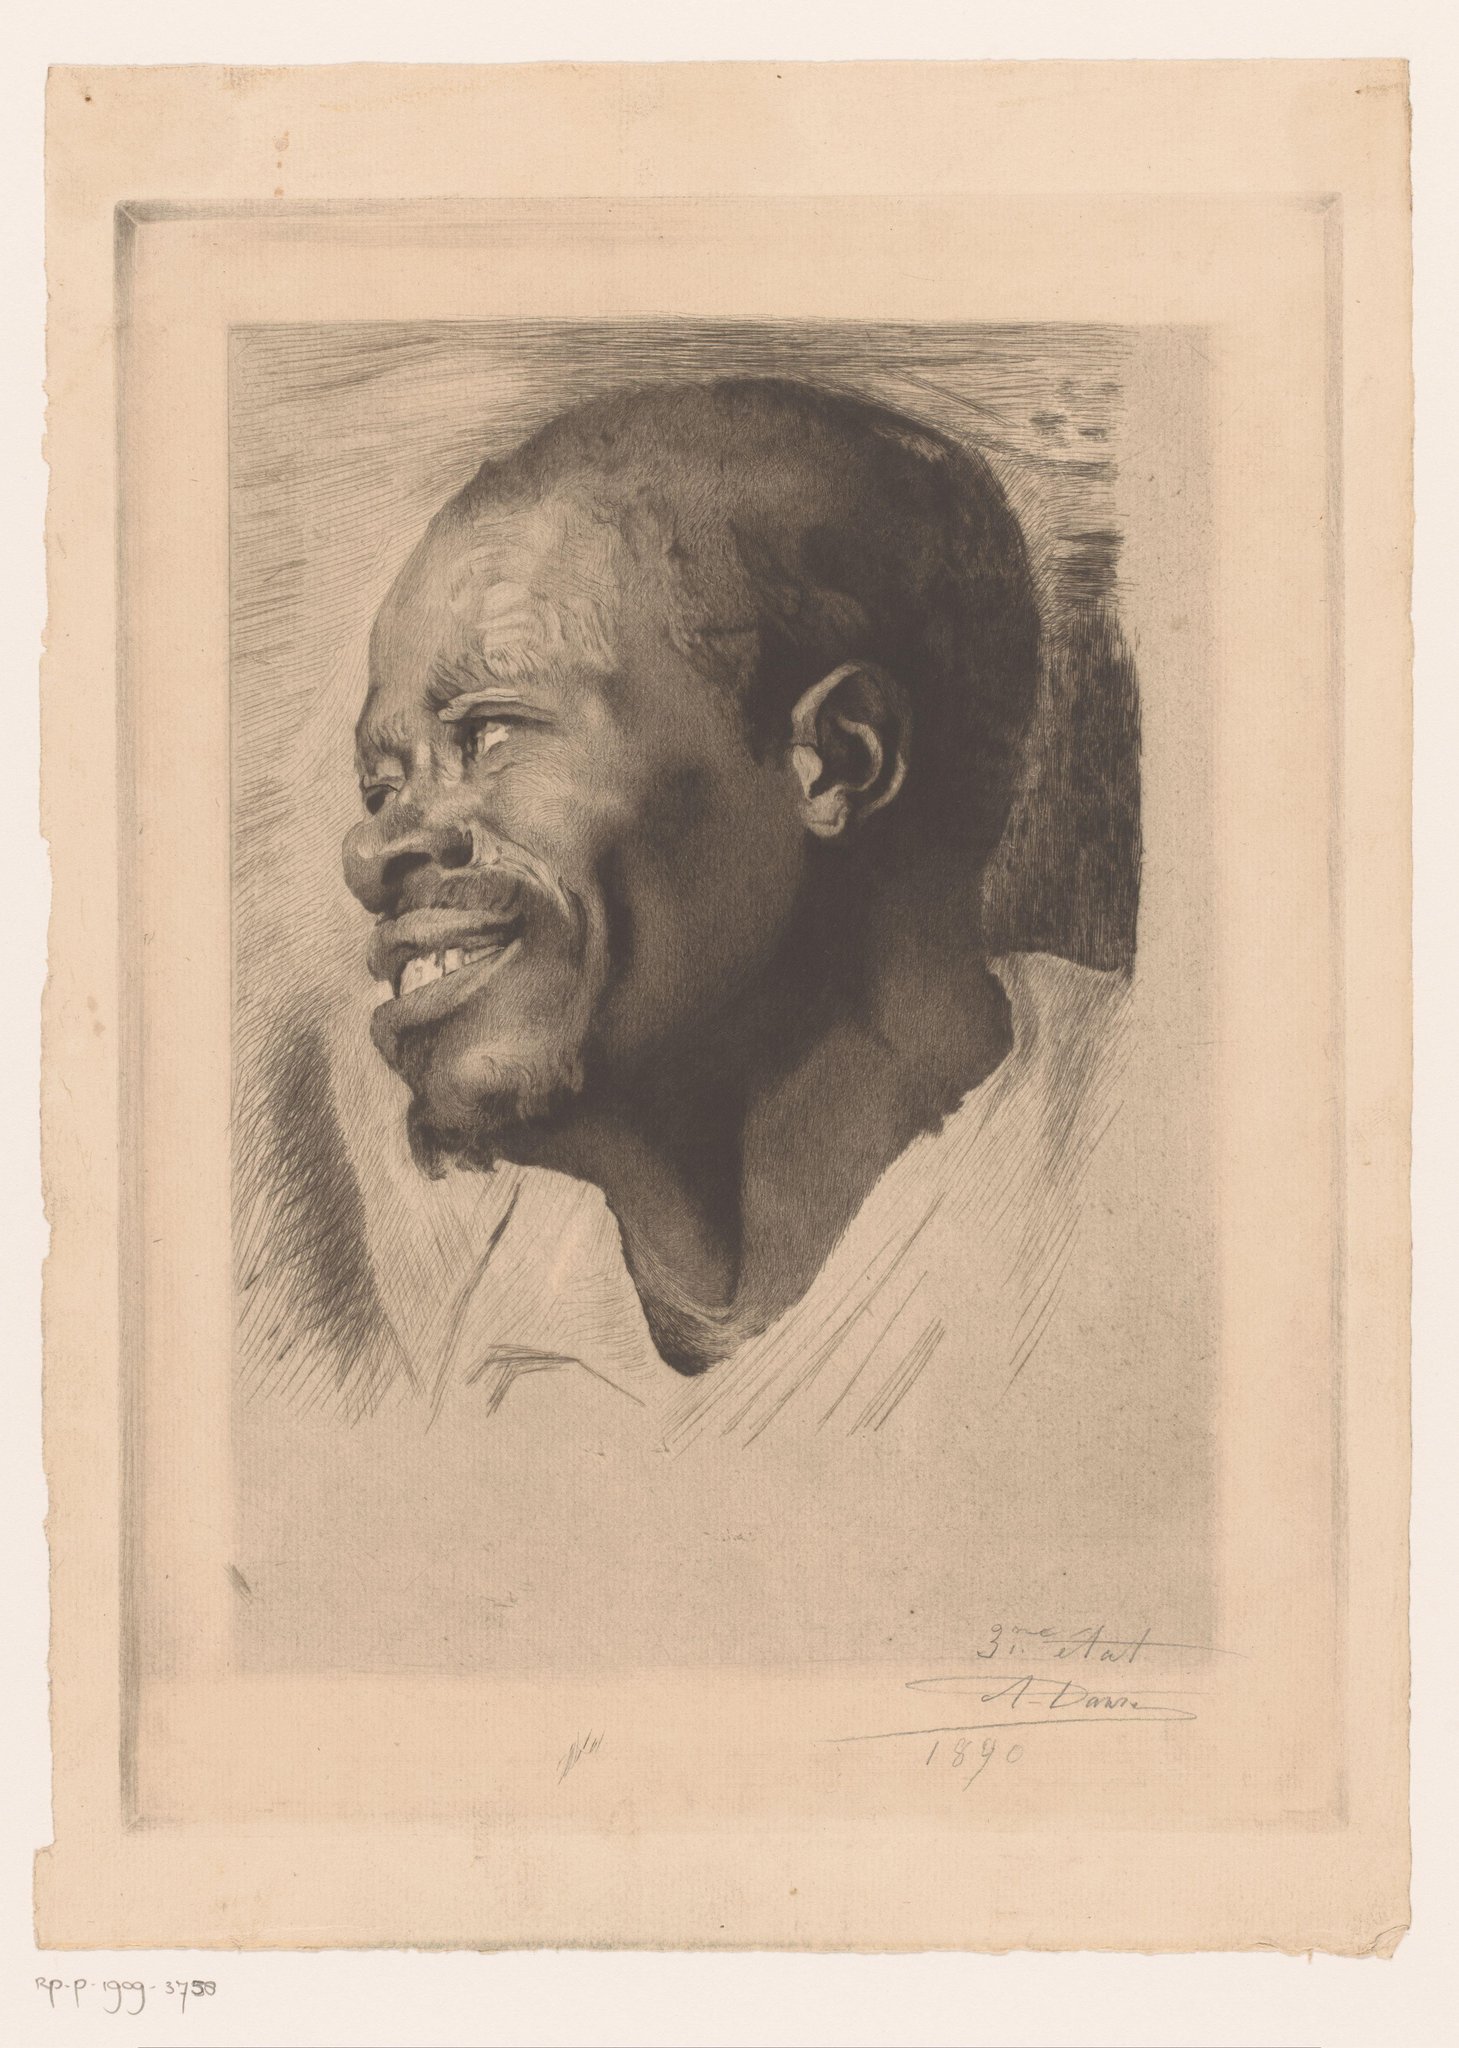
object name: print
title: Portret van een onbekende man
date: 1890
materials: paper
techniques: drypoint, etching, intaglio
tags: africans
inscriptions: annotation: ‘3me état’, collector's mark: Lugt 2228